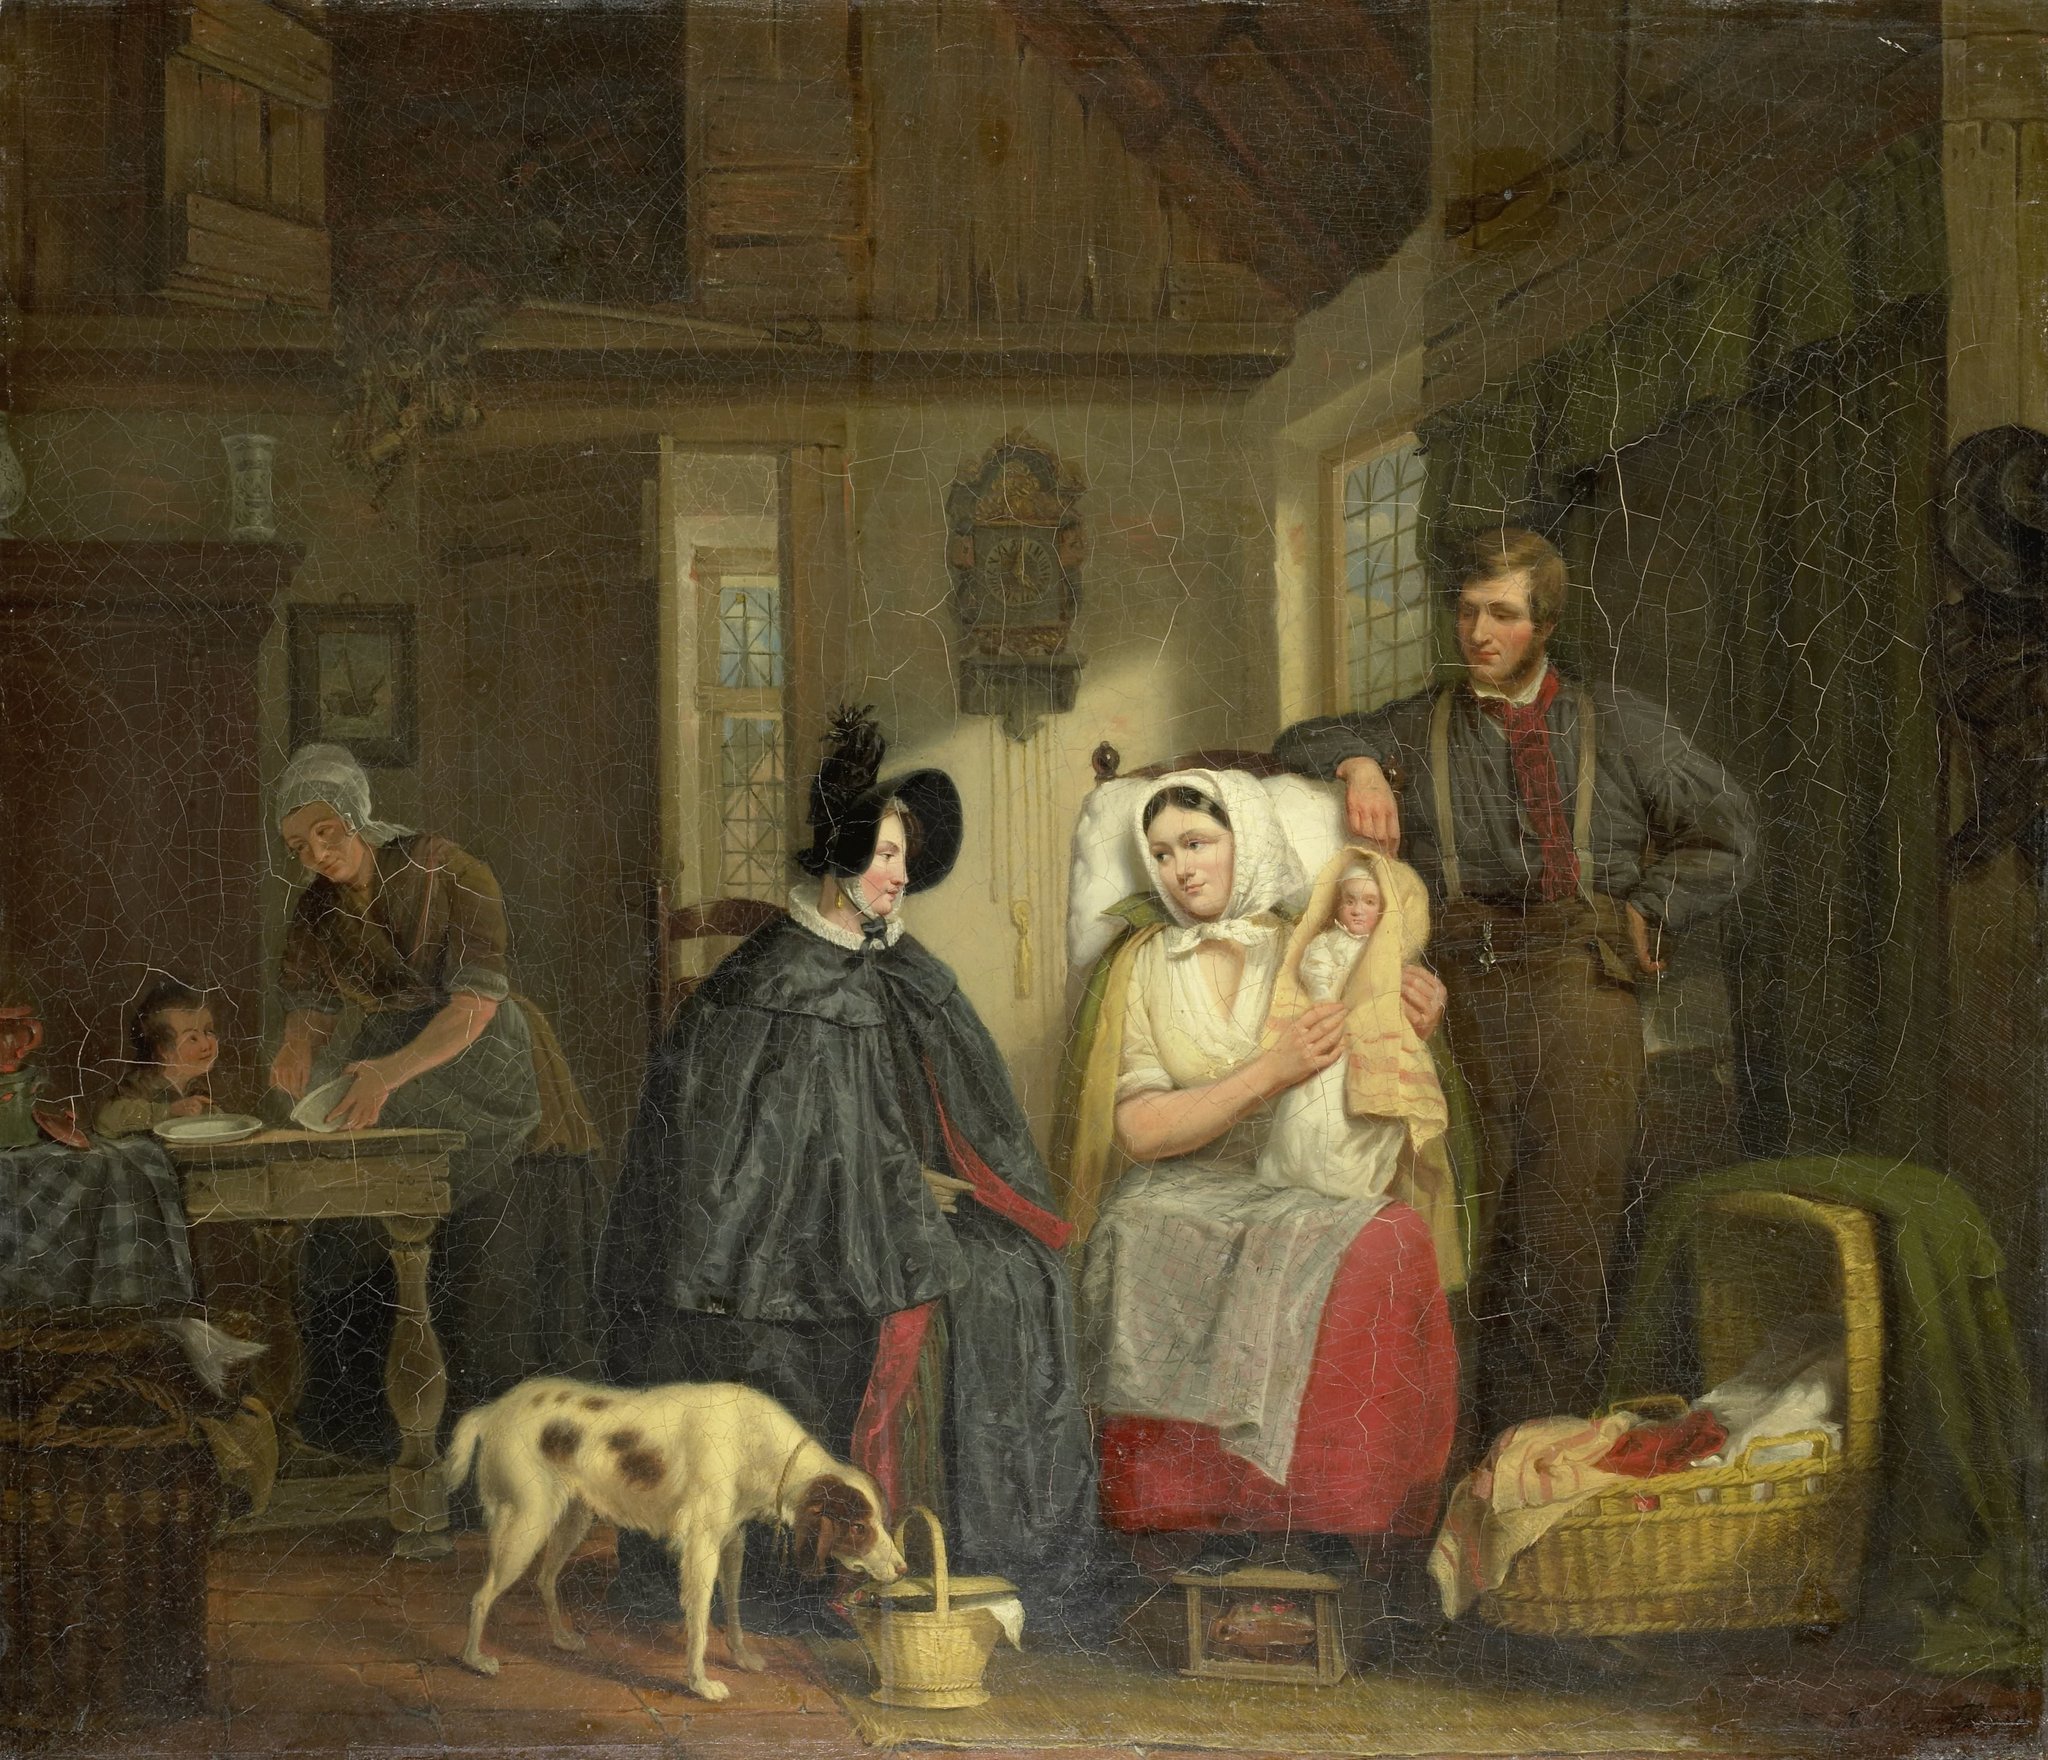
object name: painting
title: Visit to a New Mother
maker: moritz calisch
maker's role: draughtsman, print maker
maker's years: 1819-1870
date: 1835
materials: canvas, oil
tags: visiting the new mother, lying-in visit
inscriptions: signature and date: ‘M. Calisch fec.t 1835’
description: Interieur met een vrouw die een bezoek brengt aan een jonge moeder. De kraamvrouw zit in een stoel met het kind op de arm, naast de stoel staat de vader. Op de vloer een wieg, stoofje en een hond die snuffelt aan een mand. Linksachter bereidt een meid eten voor een kind. Aan de muur een stoelklok.